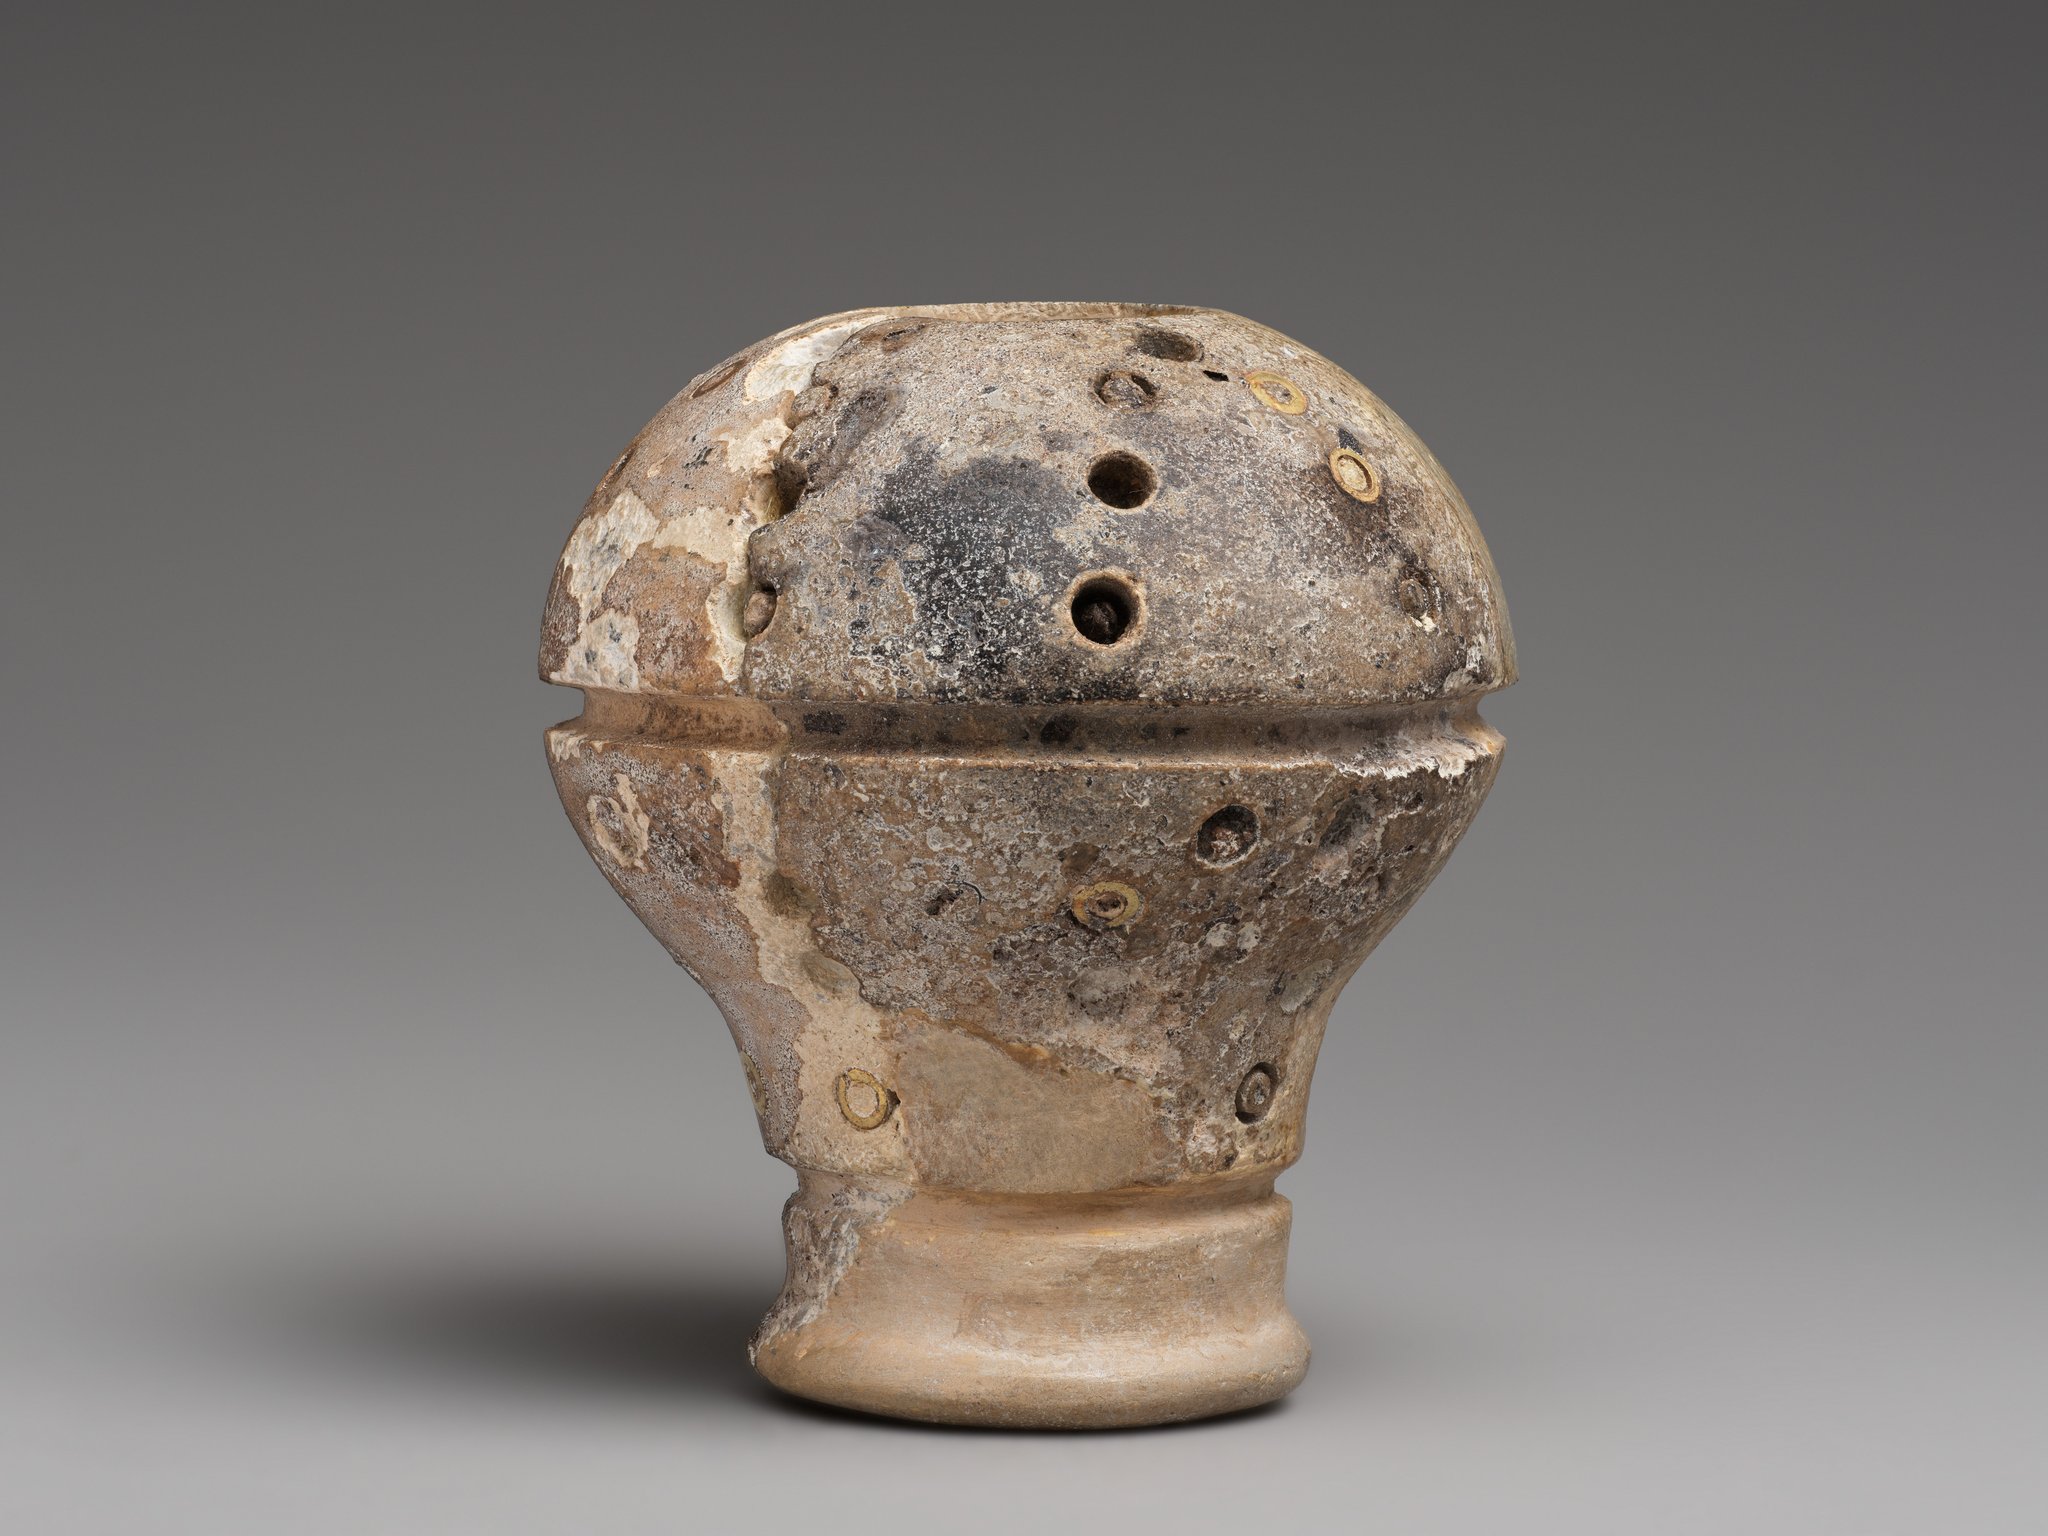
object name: mace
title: Mace head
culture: iranian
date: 900-801 BCE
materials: gold, limestone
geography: iran